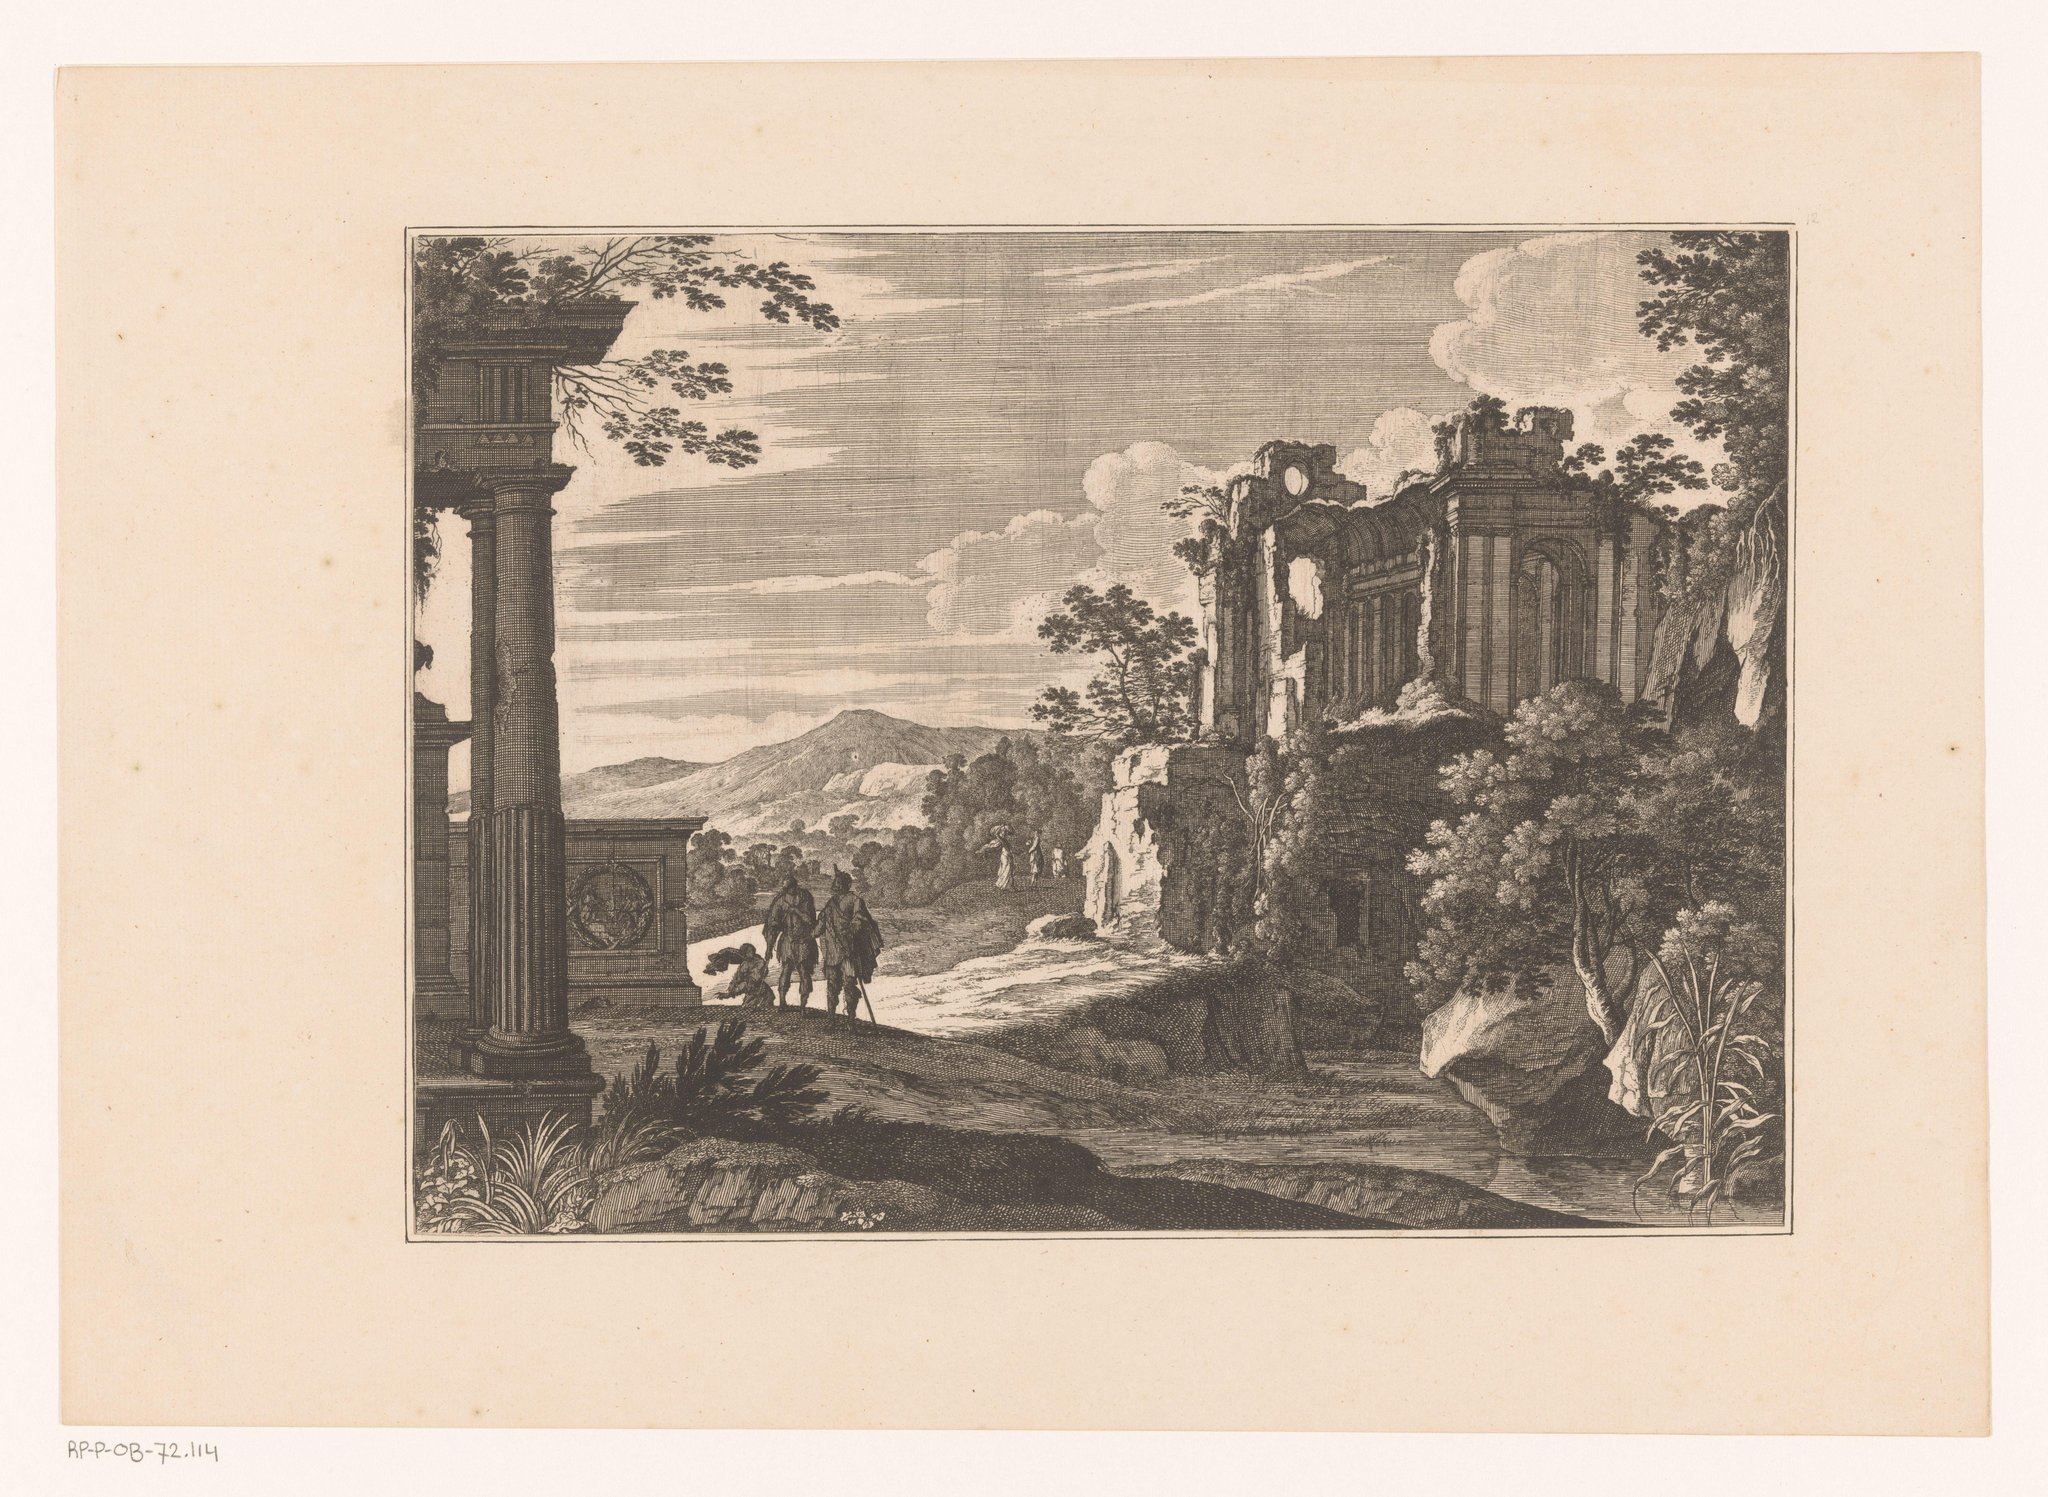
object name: print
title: Landschap met ruïnes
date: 1613-1695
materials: paper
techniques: etching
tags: landscape with ruins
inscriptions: collector's mark: Lugt 240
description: Prenten met het signatuur 'Perelle' kunnen zowel door vader Gabriel als door zonen Nicolas en Adam gemaakt zijn.